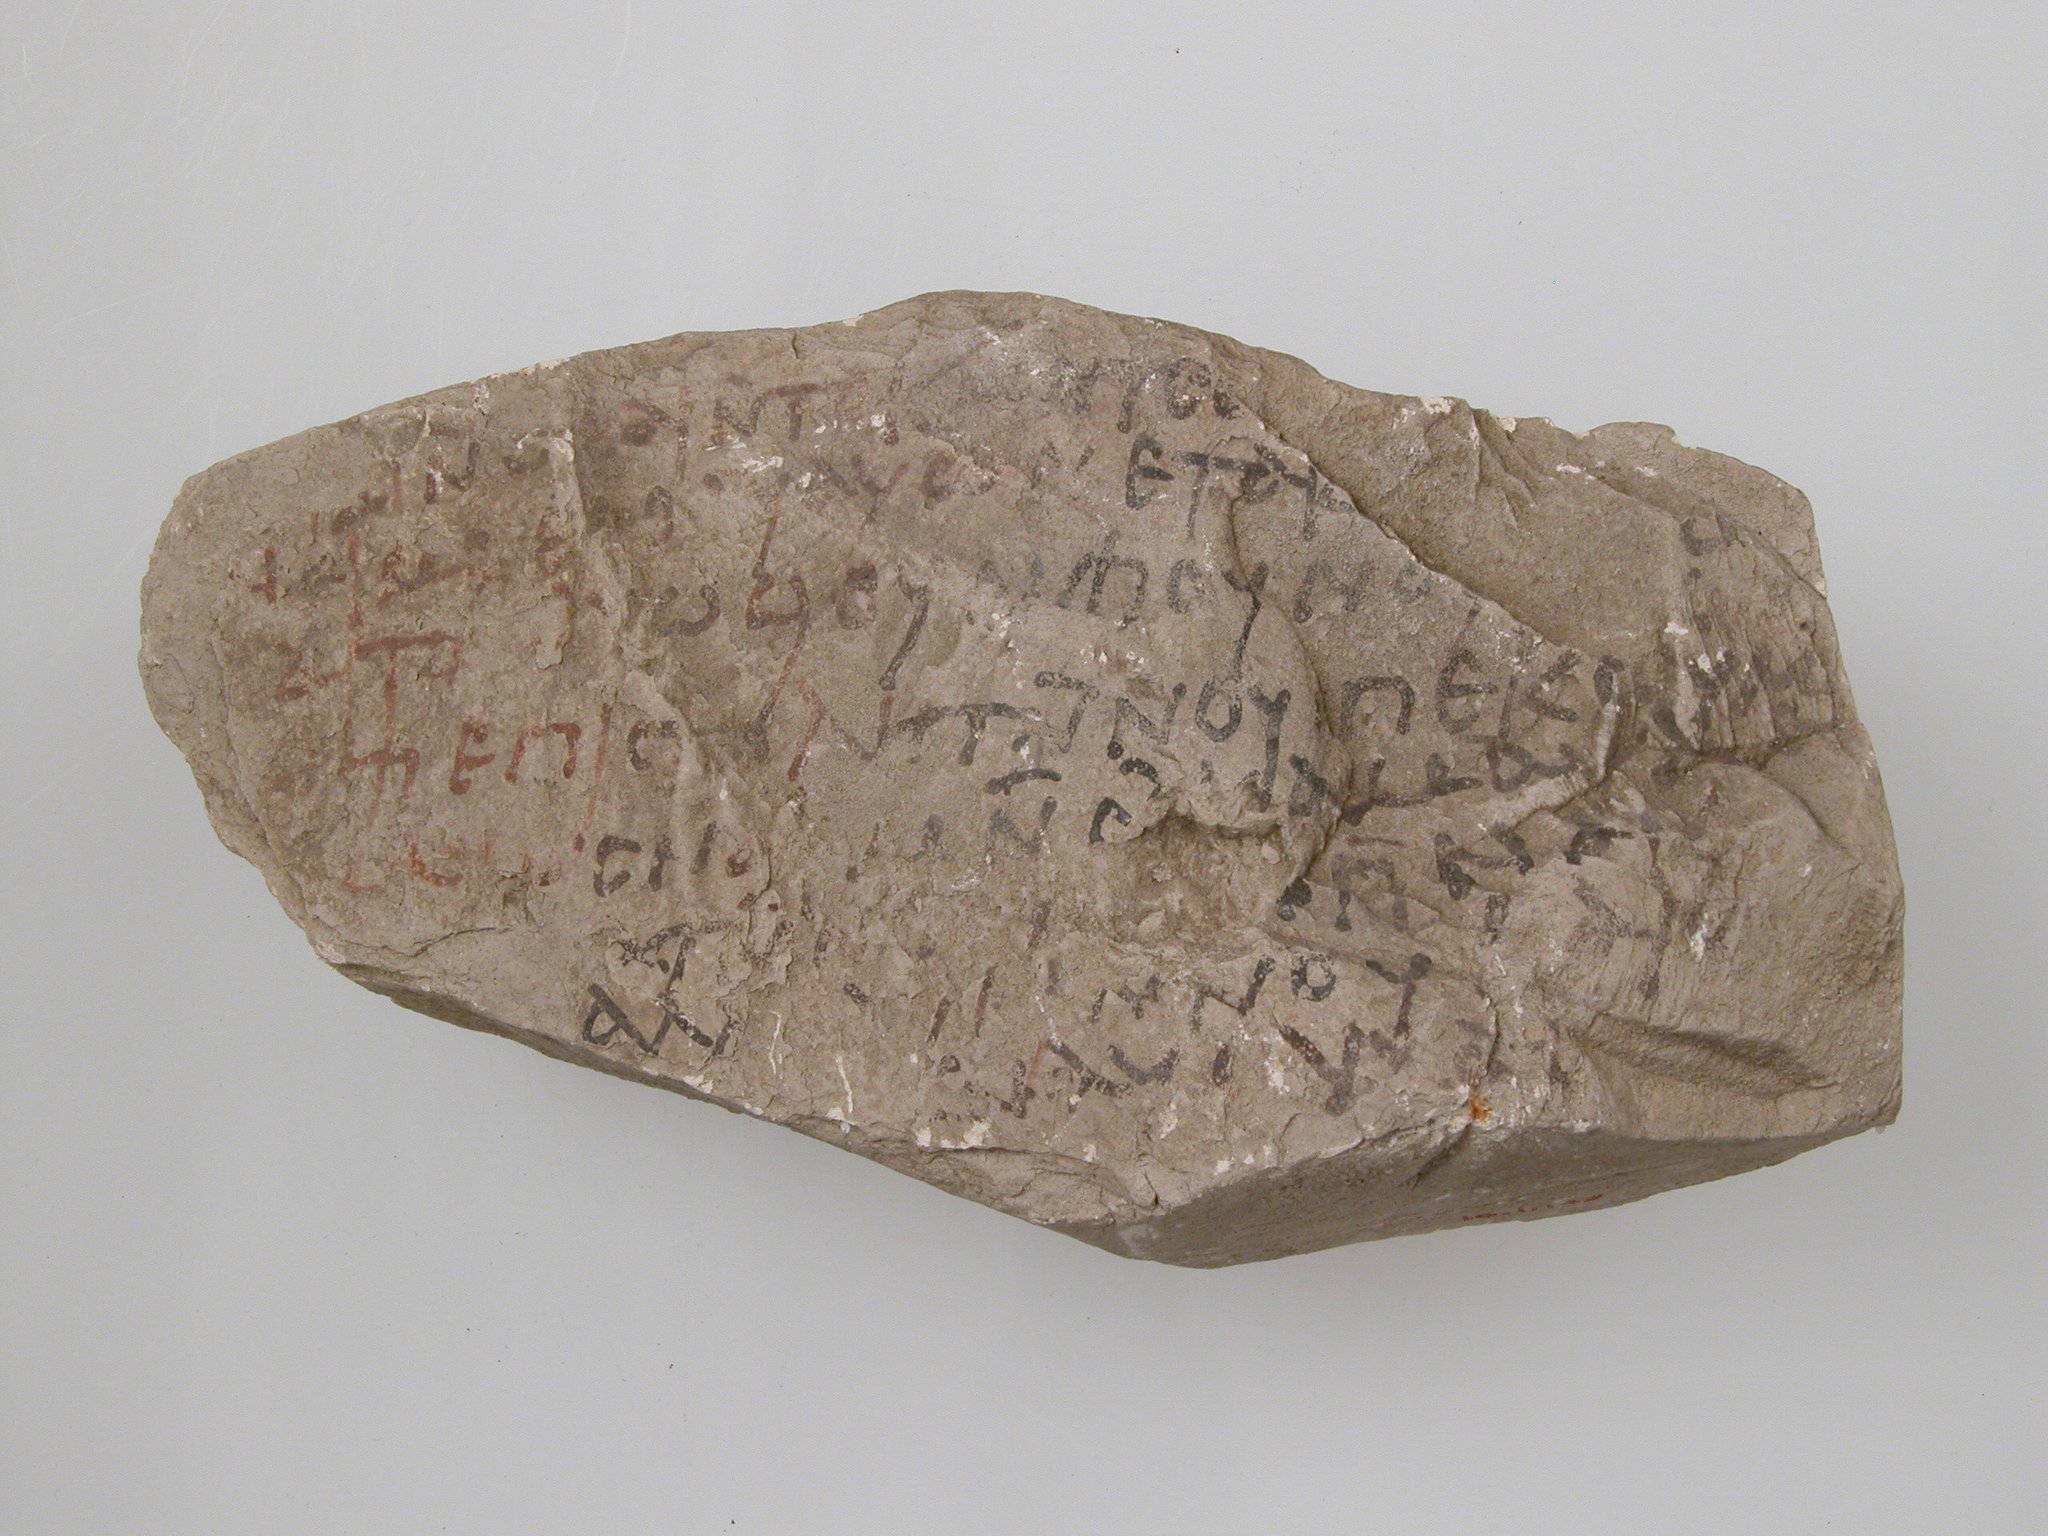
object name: ostrakon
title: Ostrakon with a Letter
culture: coptic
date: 600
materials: ink, limestone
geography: egypt